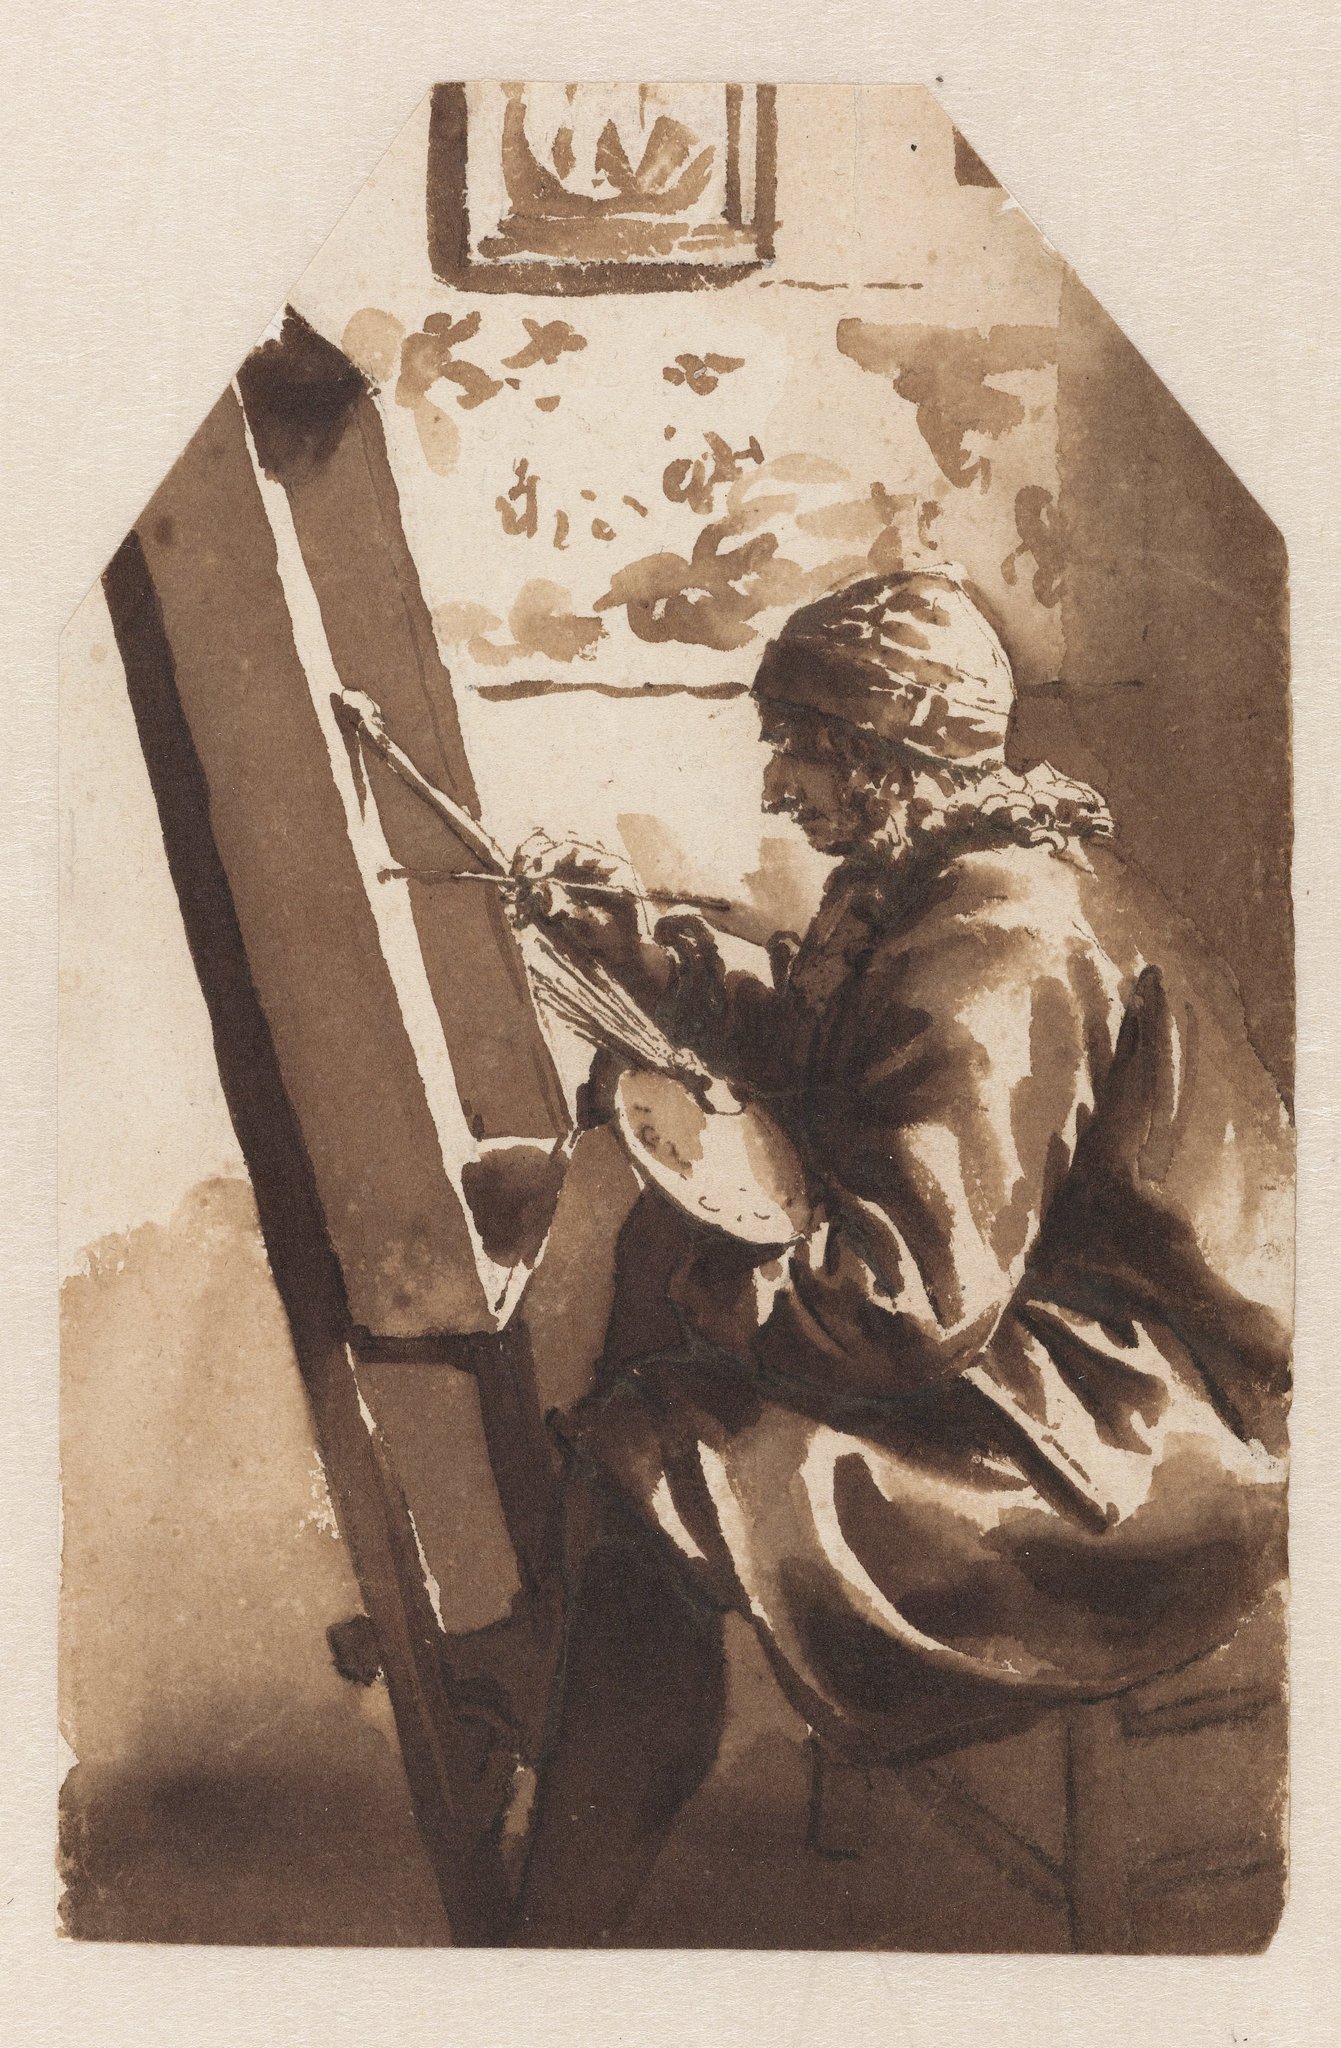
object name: drawing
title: A Painter Seated at his Easel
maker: jan de bisschop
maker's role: draughtsman, print maker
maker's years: 1628-1671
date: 1648-1671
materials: ink, paper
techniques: brush, pen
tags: painter at work, in his studio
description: Informally garbed in a dressing gown and a nightcap, this artist works up a detail in his painting. His hand rests on a maulstick, a tool that prevents him from smearing the wet paint. This sketch is drawn primarily with the brush. The portrait seems to be done from life and the sitter may well be one of De Bisschop’s Hague painter friends.